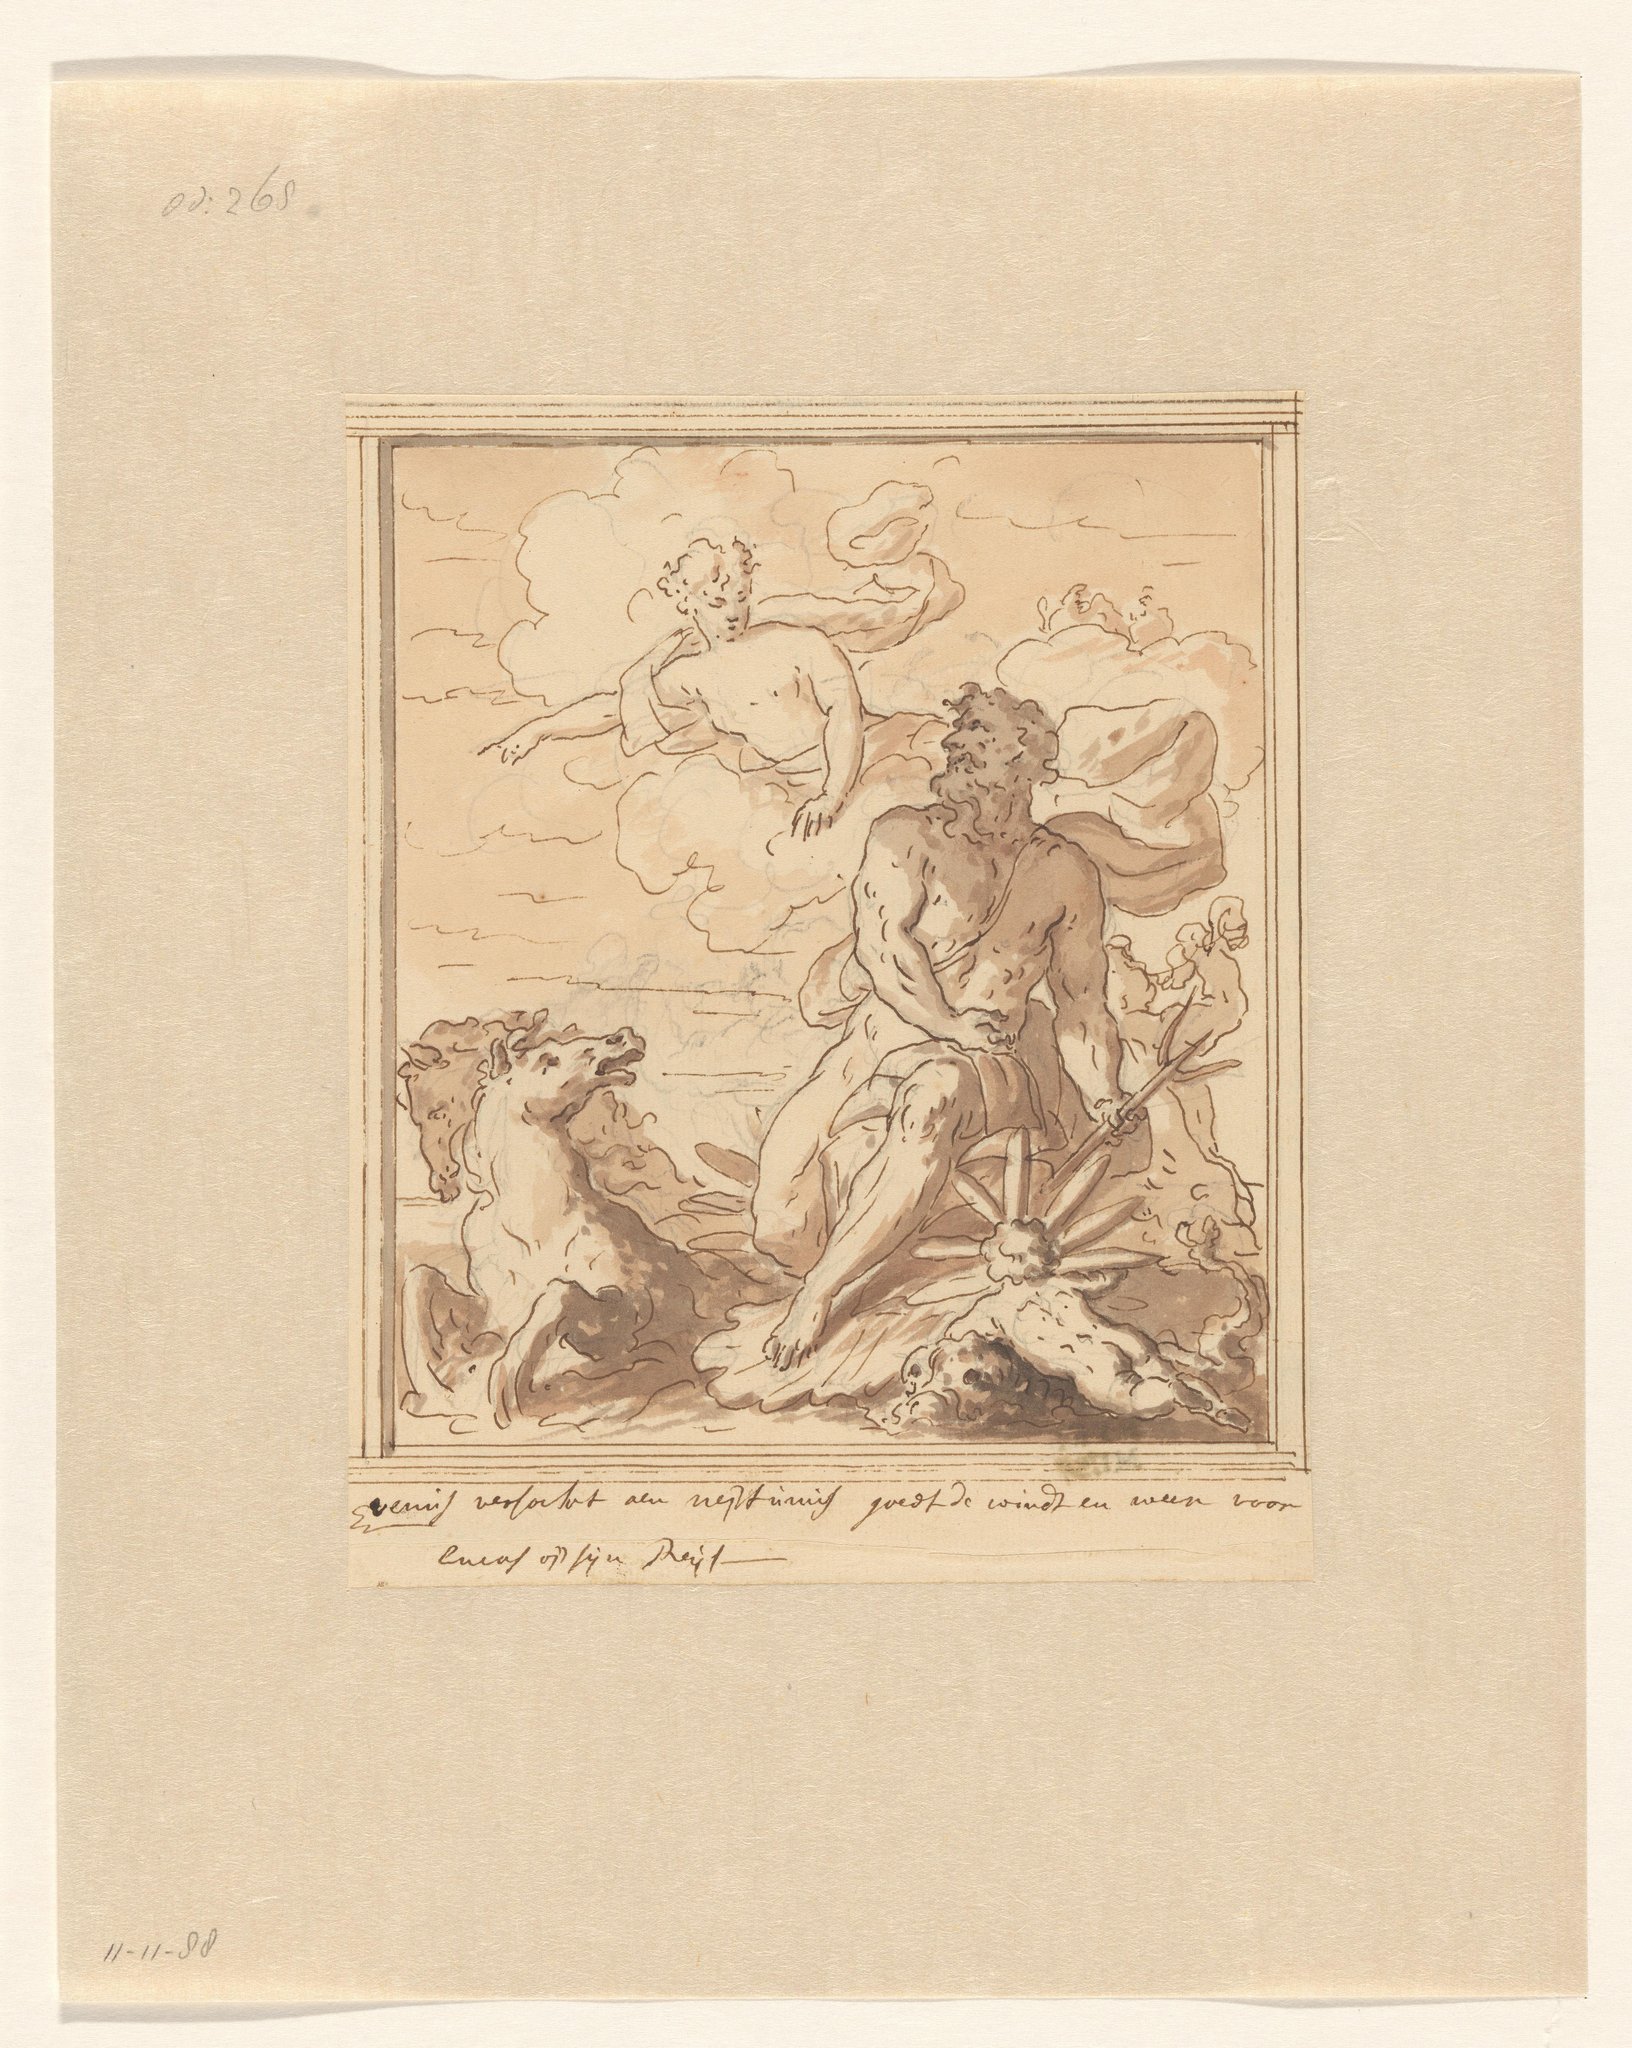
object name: drawing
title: Ontwerpen voor schilderijen met episodes uit De Aeneas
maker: mattheus terwesten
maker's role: draughtsman, painter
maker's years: 1670-1757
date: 1700-1704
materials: ink, paper, pencil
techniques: brush, pen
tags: neptune quieting the storm, 'quos ego' (virgil, aeneid i 135)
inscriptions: : ‘Venus versoekt aen Neptunus goedtde windt en weer voor Eneas op sijn reijs.’